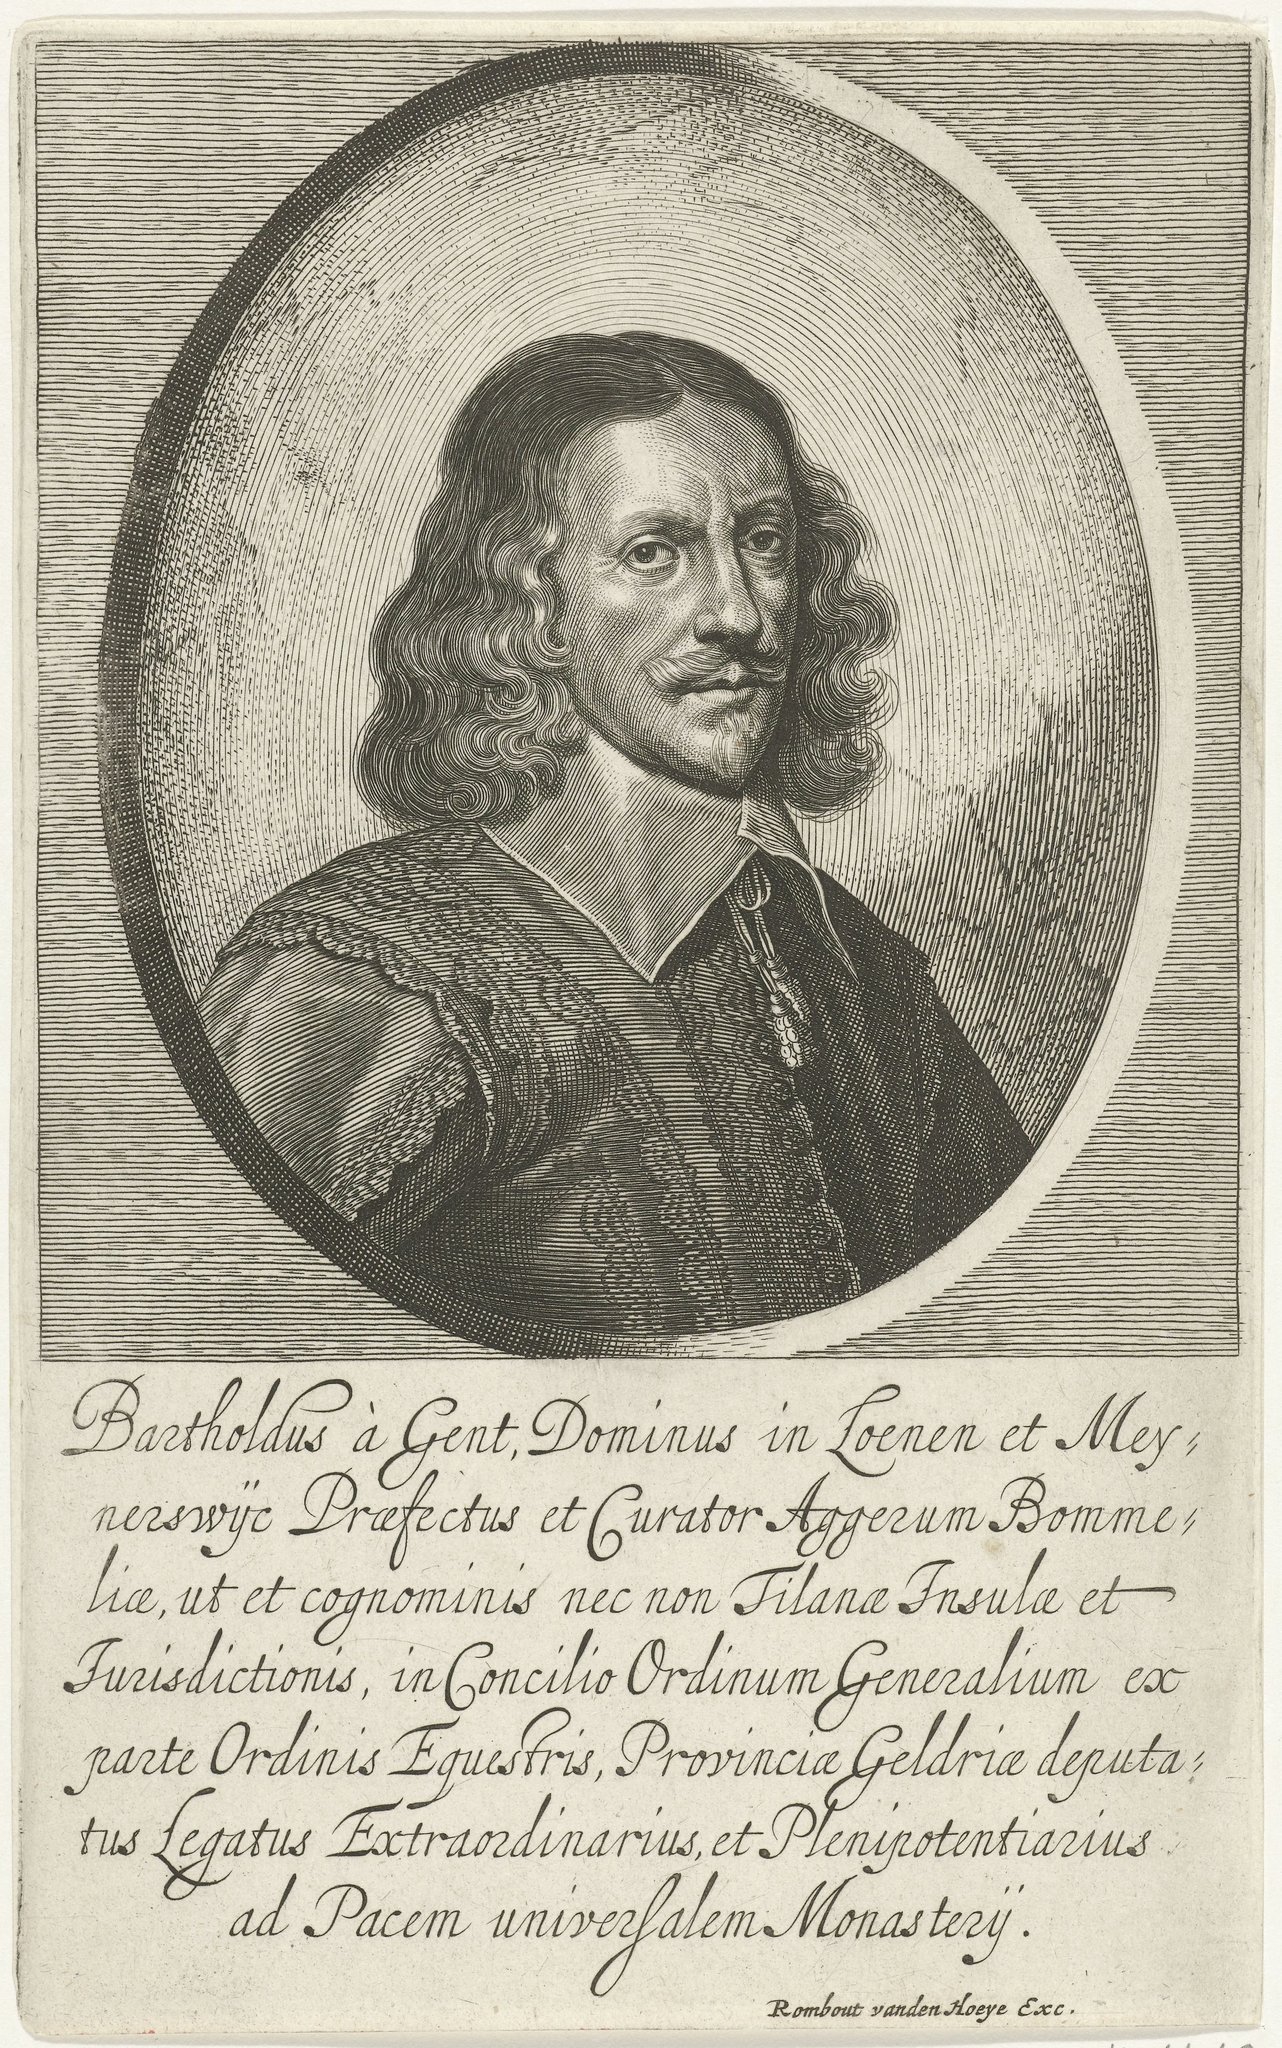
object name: print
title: Portretten van ambassadeurs van de Vrede van Munster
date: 1648-1664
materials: paper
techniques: engraving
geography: amsterdam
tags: ambassadeur, staatsman, barthold van gent, vrede van münster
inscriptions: collector's mark: Lugt 2228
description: Buste naar rechts van Barthold van Gent, heer van Meynerswijck in een ovaal. Onder het portret zeven regels in het Latijn. Prent uit een serie portretten van ambassadeurs betrokken bij het vredesverdrag van Munster.